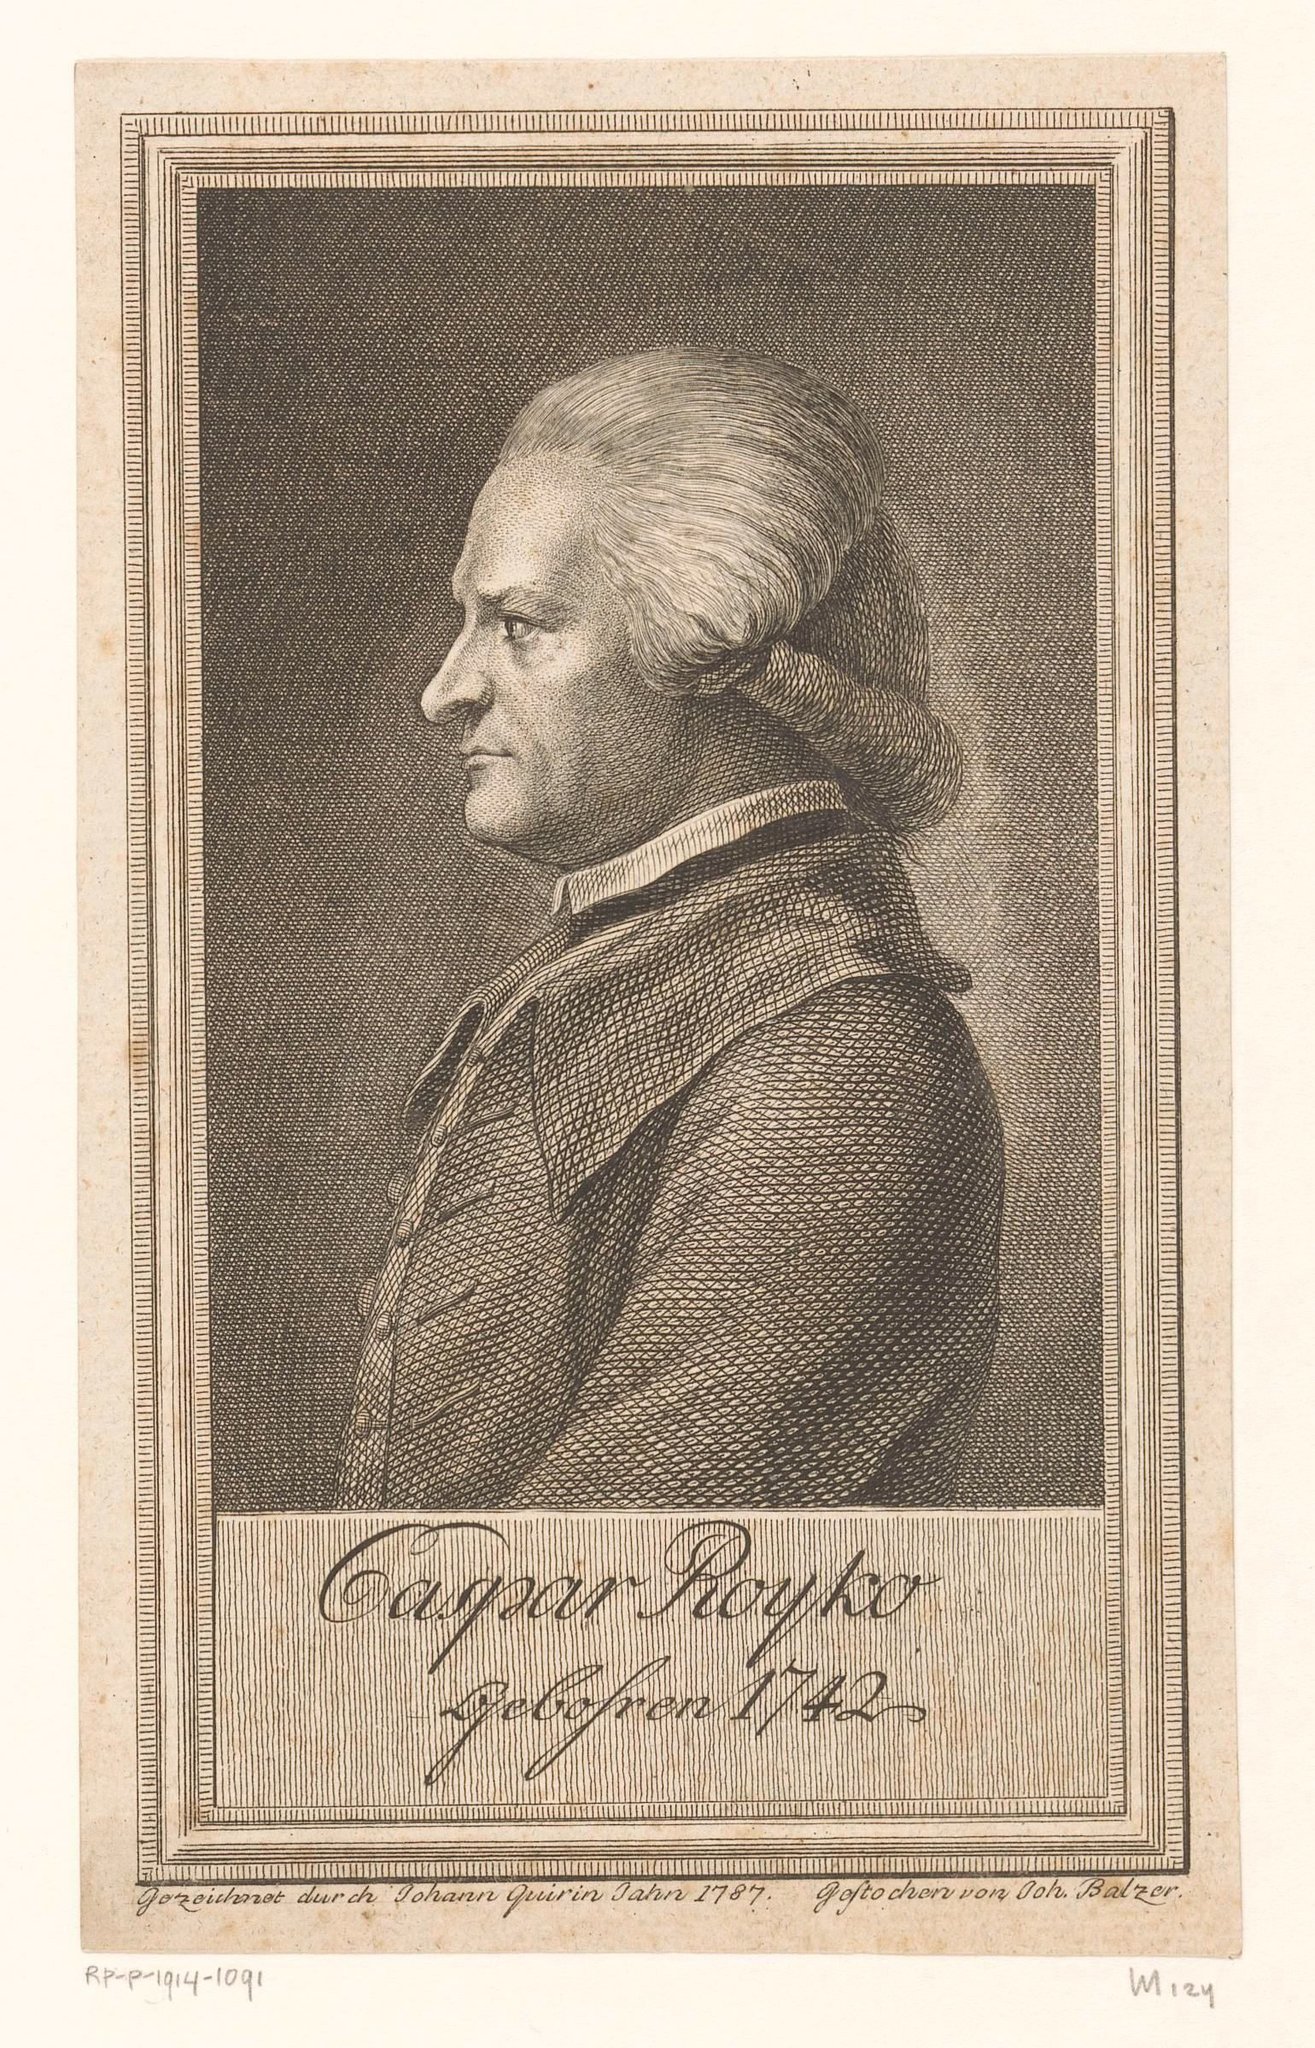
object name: print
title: Portret van Caspar Royko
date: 1787-1799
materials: paper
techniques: engraving, etching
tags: historical persons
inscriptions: collector's mark: Lugt 2228